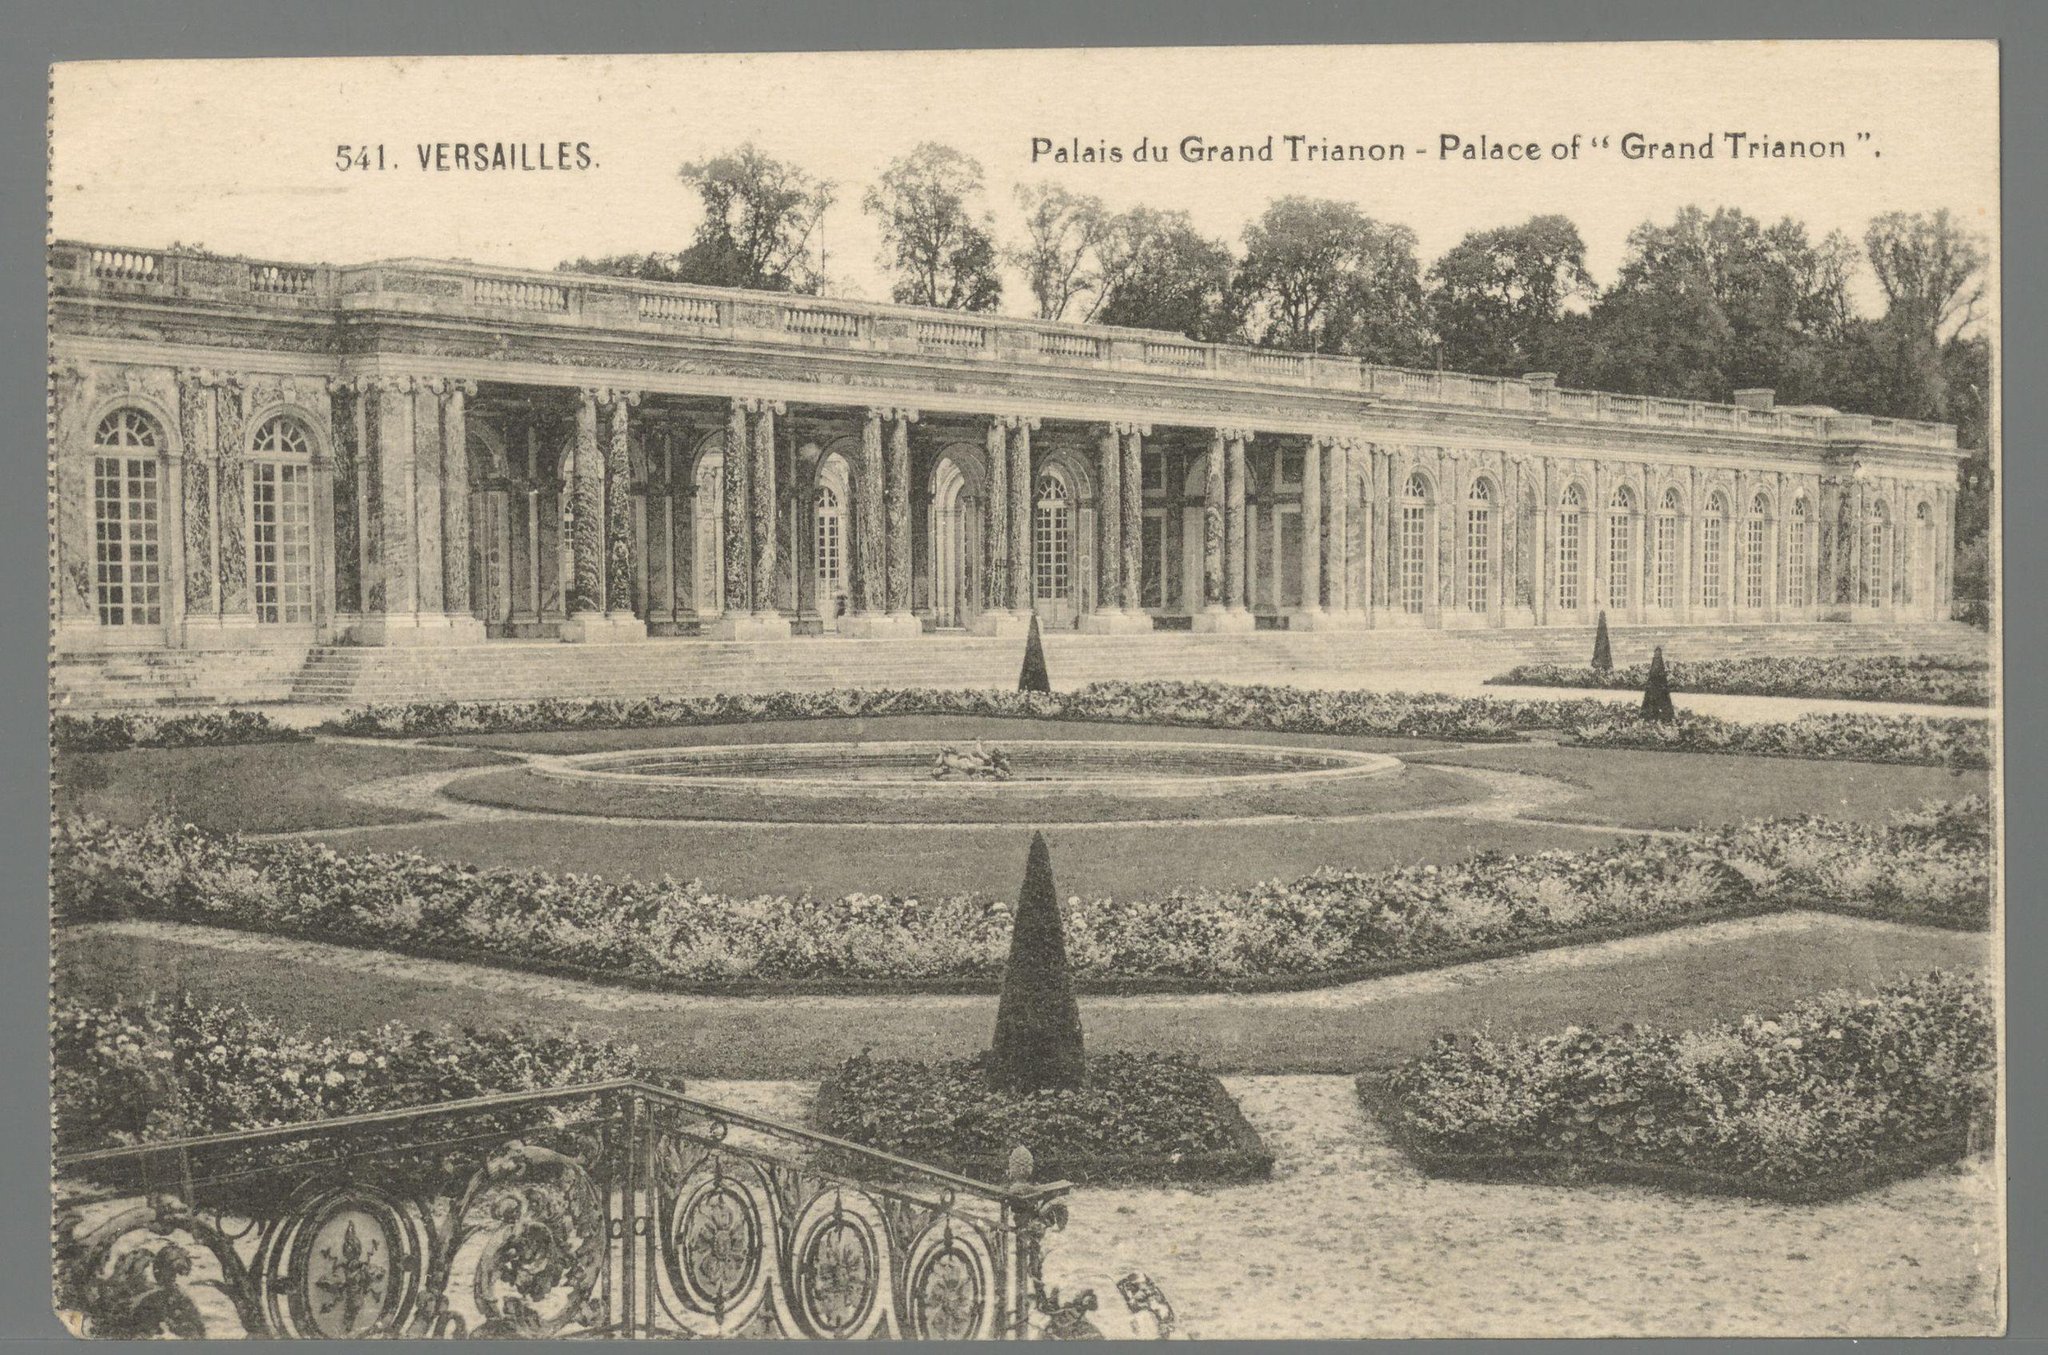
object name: photomechanical print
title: Versailles. Palais du Grand Trianon / Palace of "Grand Trianon"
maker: Anonymous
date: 1903-1937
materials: cardboard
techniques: photograph, writing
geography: versailles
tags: castle, french or architectonic garden; formal garden